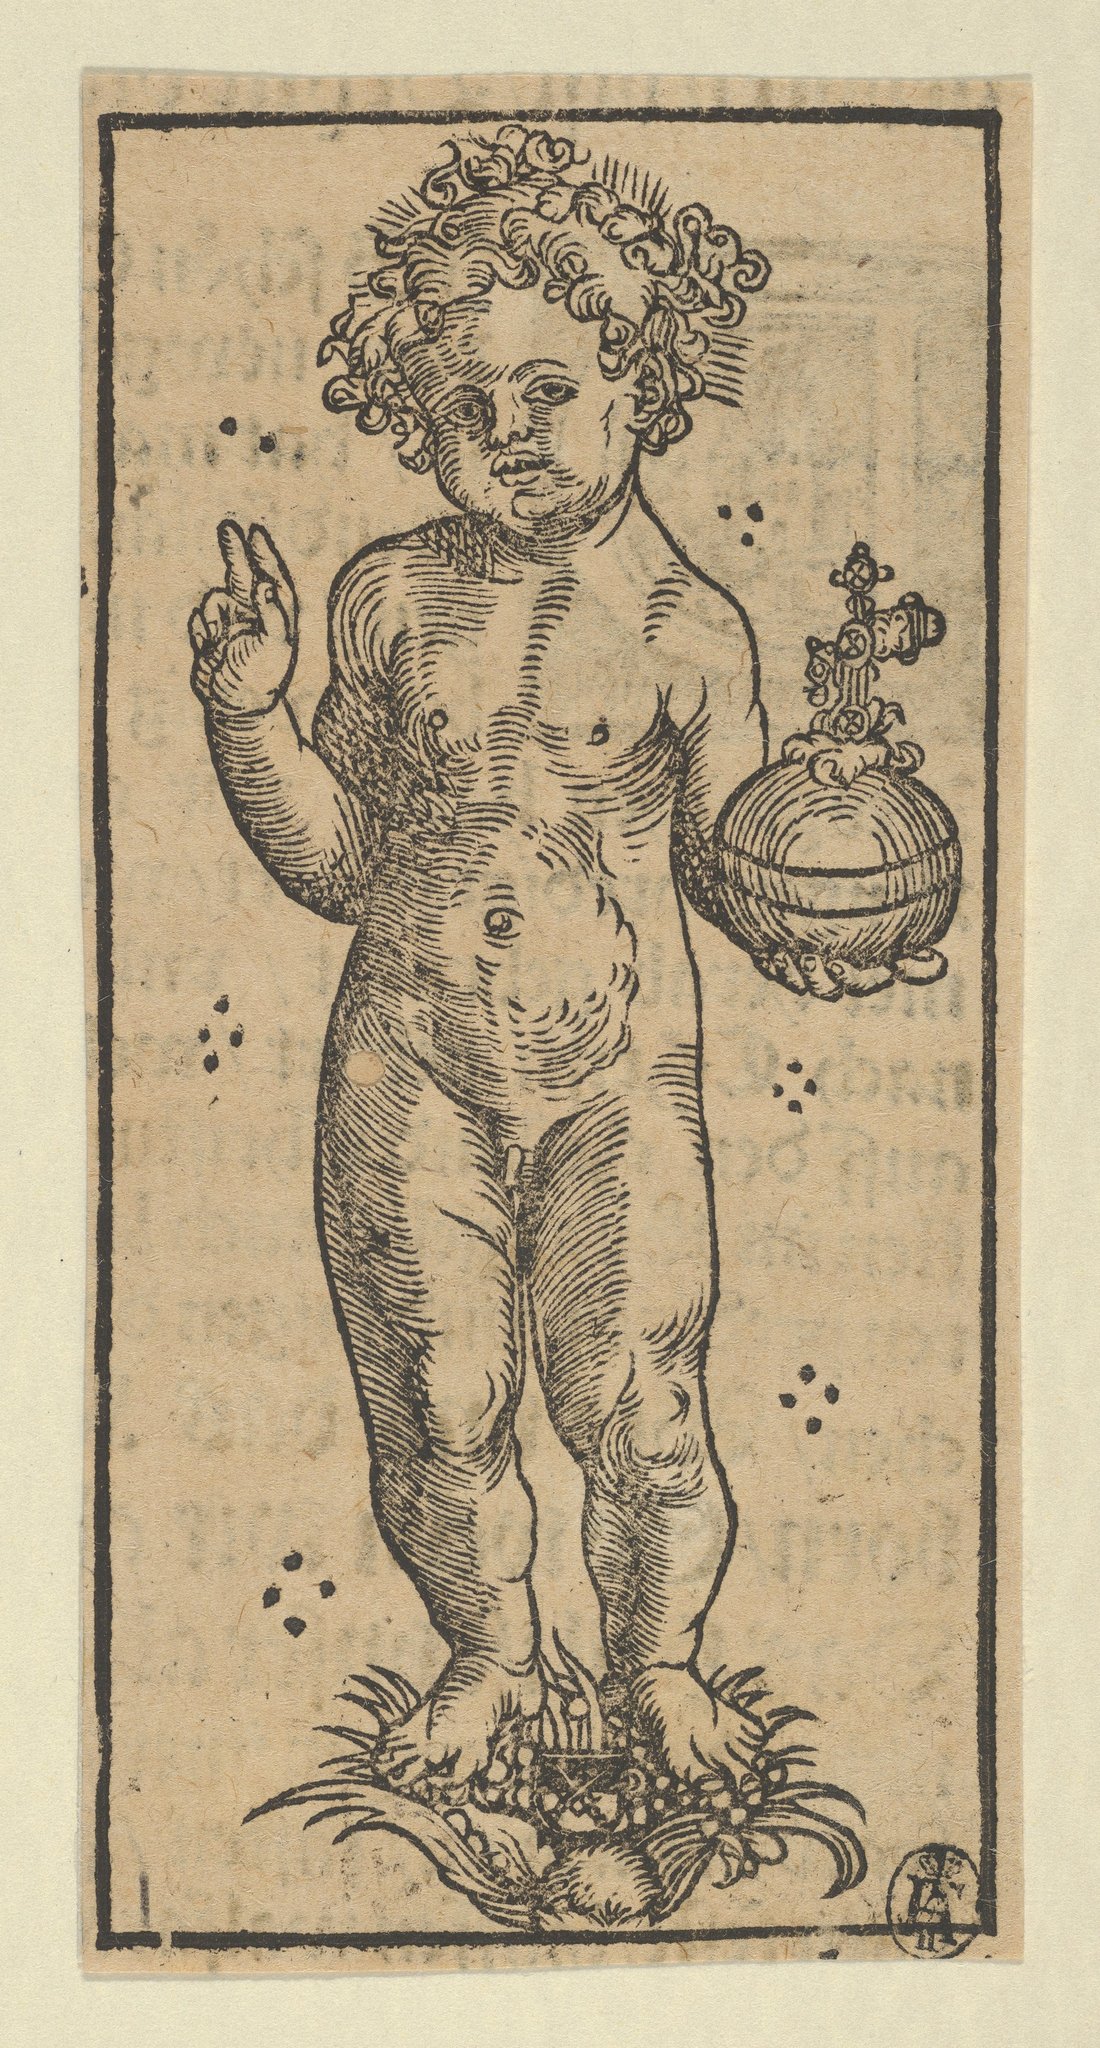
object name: print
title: Silver Statuette of the Christ Child, from the "Wittenberg Reliquaries"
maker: lucas cranach the elder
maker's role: artist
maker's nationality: german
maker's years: 1472-1553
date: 1472-1553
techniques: woodcut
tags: christ